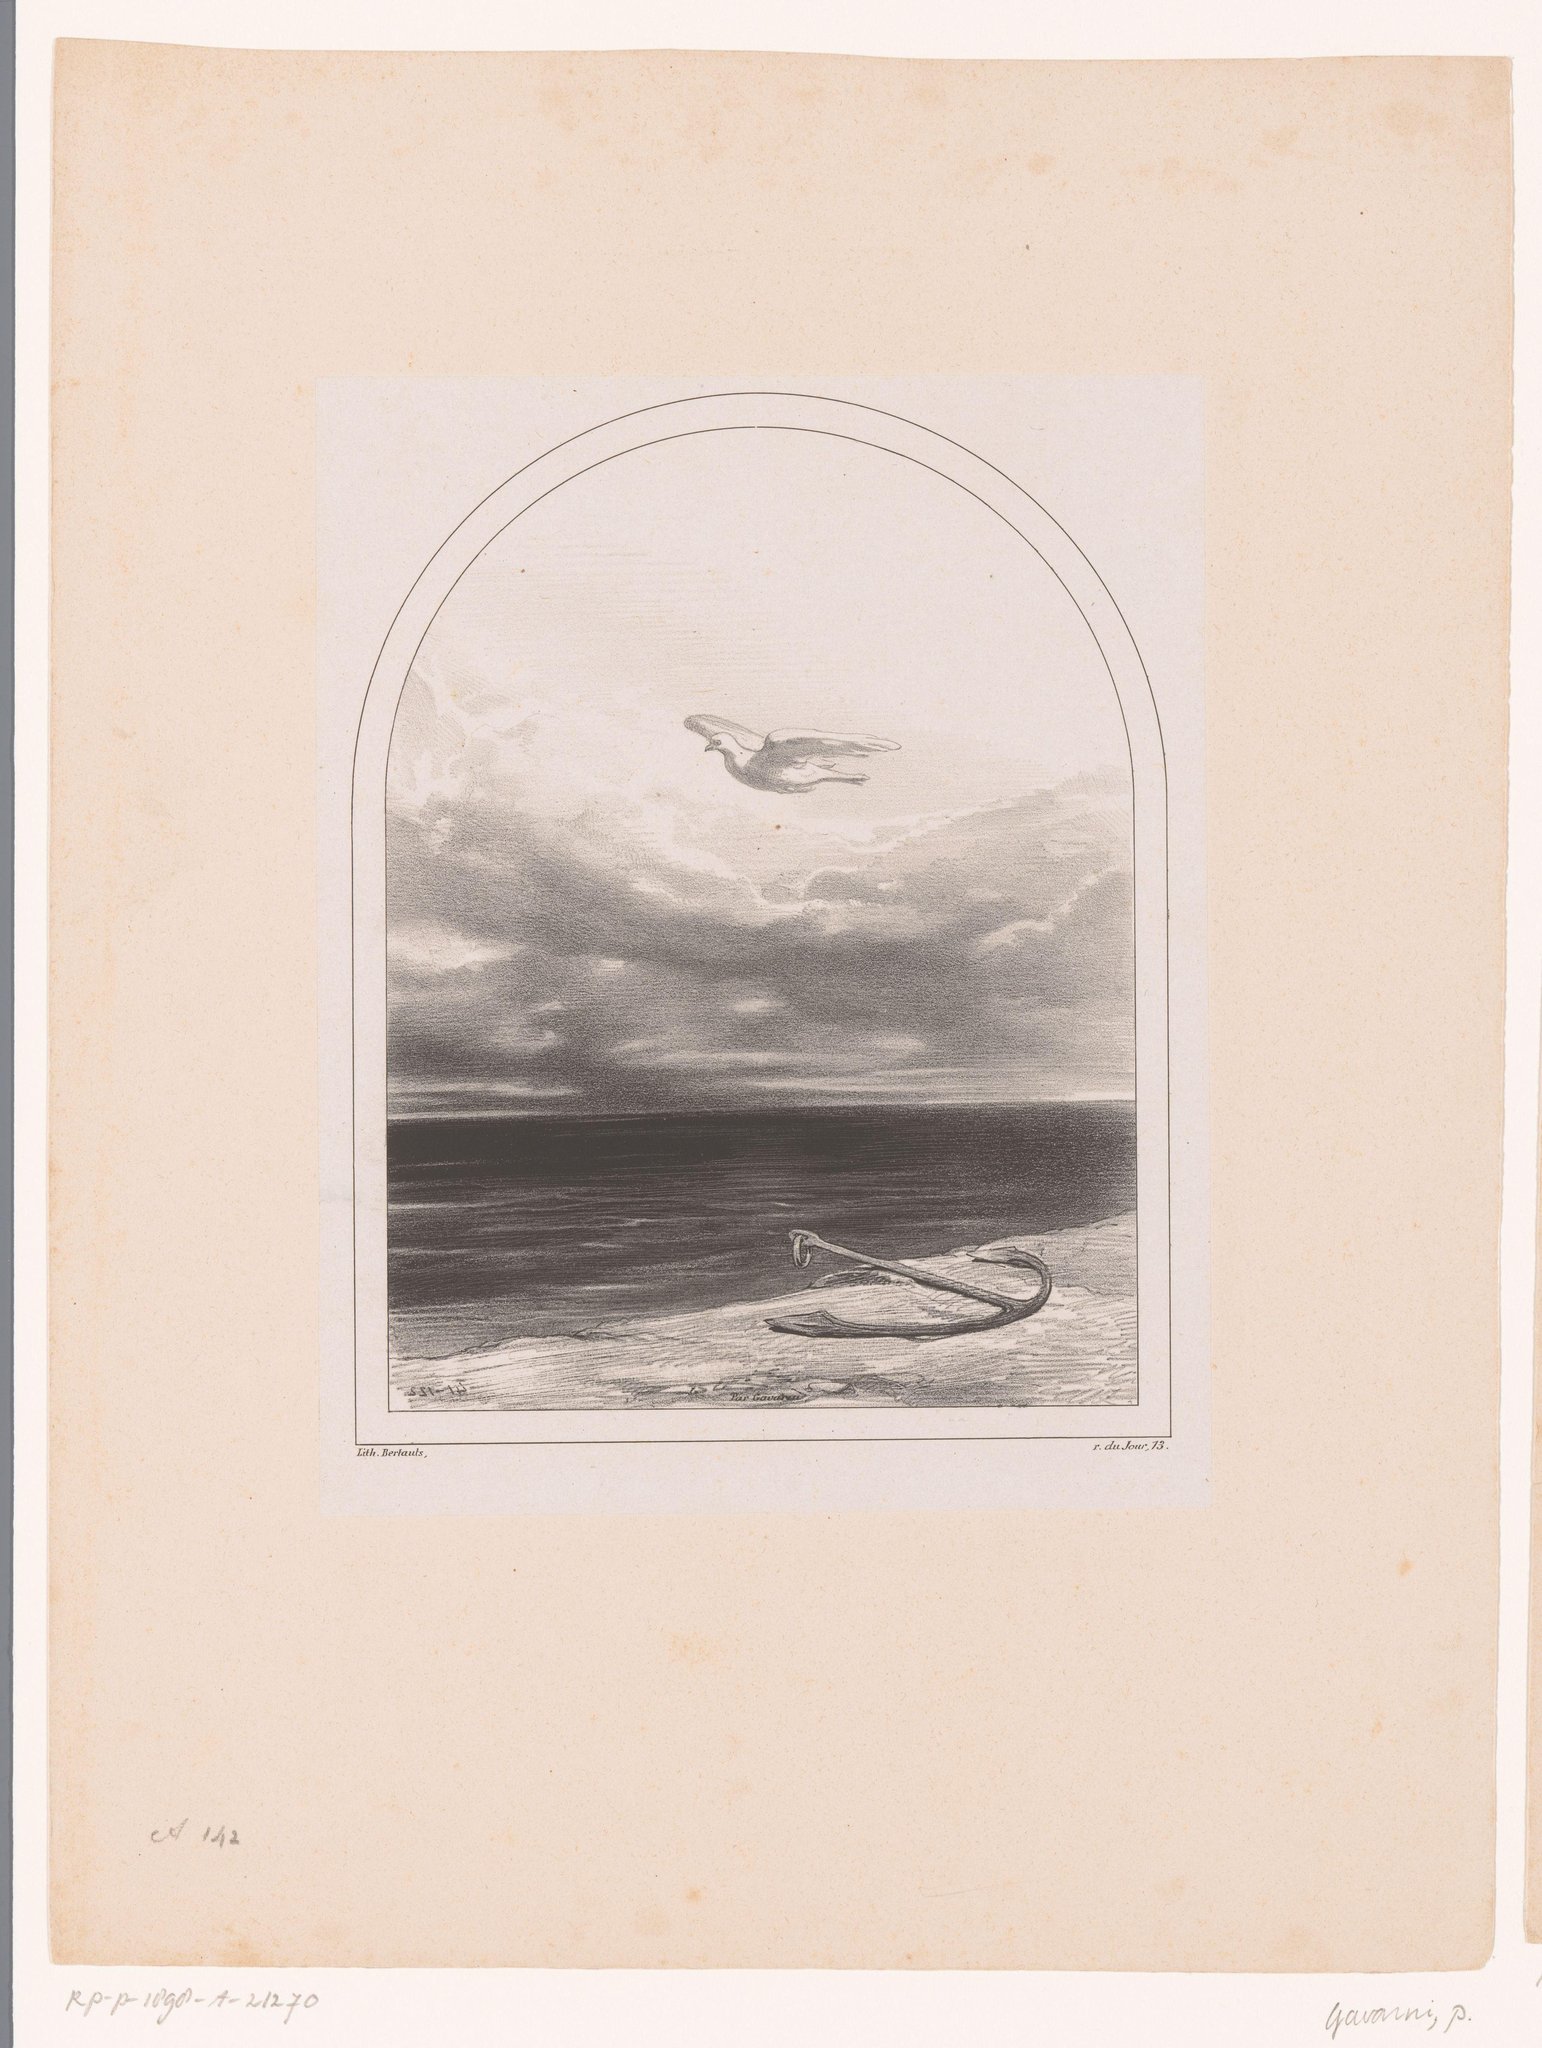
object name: print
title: Blanche colombe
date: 1841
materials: paper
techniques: lithograph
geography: paris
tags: parts of ship's exterior: anchor, beach, doves, pigeons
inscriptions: collector's mark: Lugt 964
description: Prent gebruikt als illustratie voor de melodie Blanche colombe, in het album met bladmuziek Les Lys et les roses.